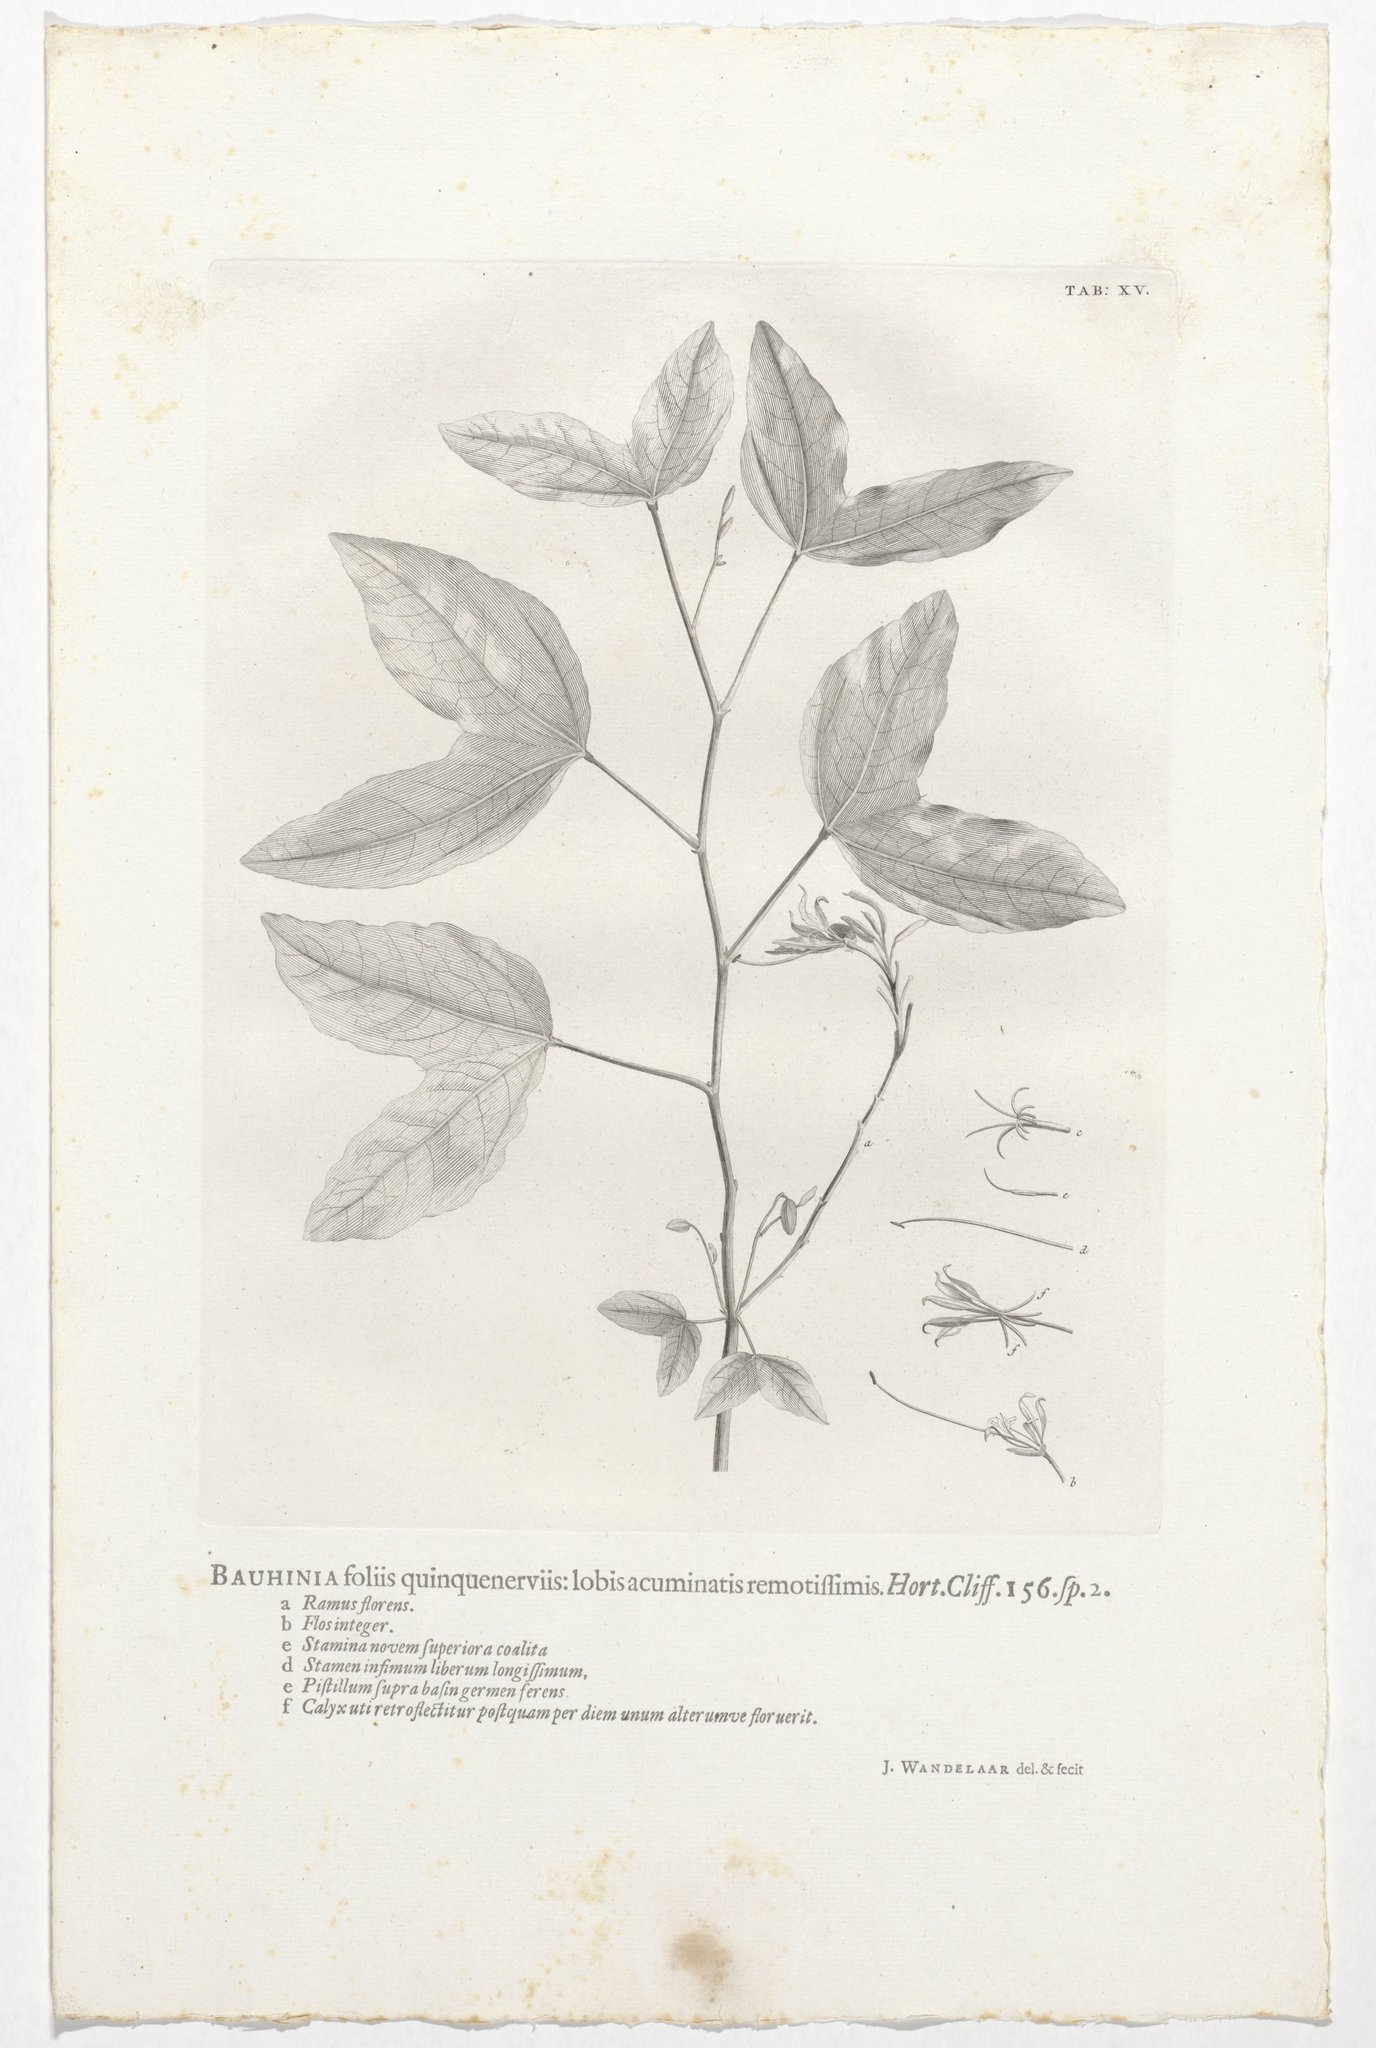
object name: print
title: Bauhinia foliis quinquenerviis: lobis acuminatis remotissimis. Hort. Cliff. 156. sp. 2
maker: jan wandelaar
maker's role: draughtsman, print maker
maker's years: 1690-1759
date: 1738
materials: paper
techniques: etching, letterpress printing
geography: warmond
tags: flowers, plants and herbs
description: Prent gebruikt als illustratie in: Linnaeus, Carolus. Hortus Cliffortianus plantas exhibens quas in hortis tam vivis quam siccis, Hartecampi in Hollandia, coluit (...) Georgius Clifford. Amsterdam: sine nomen, 1738.